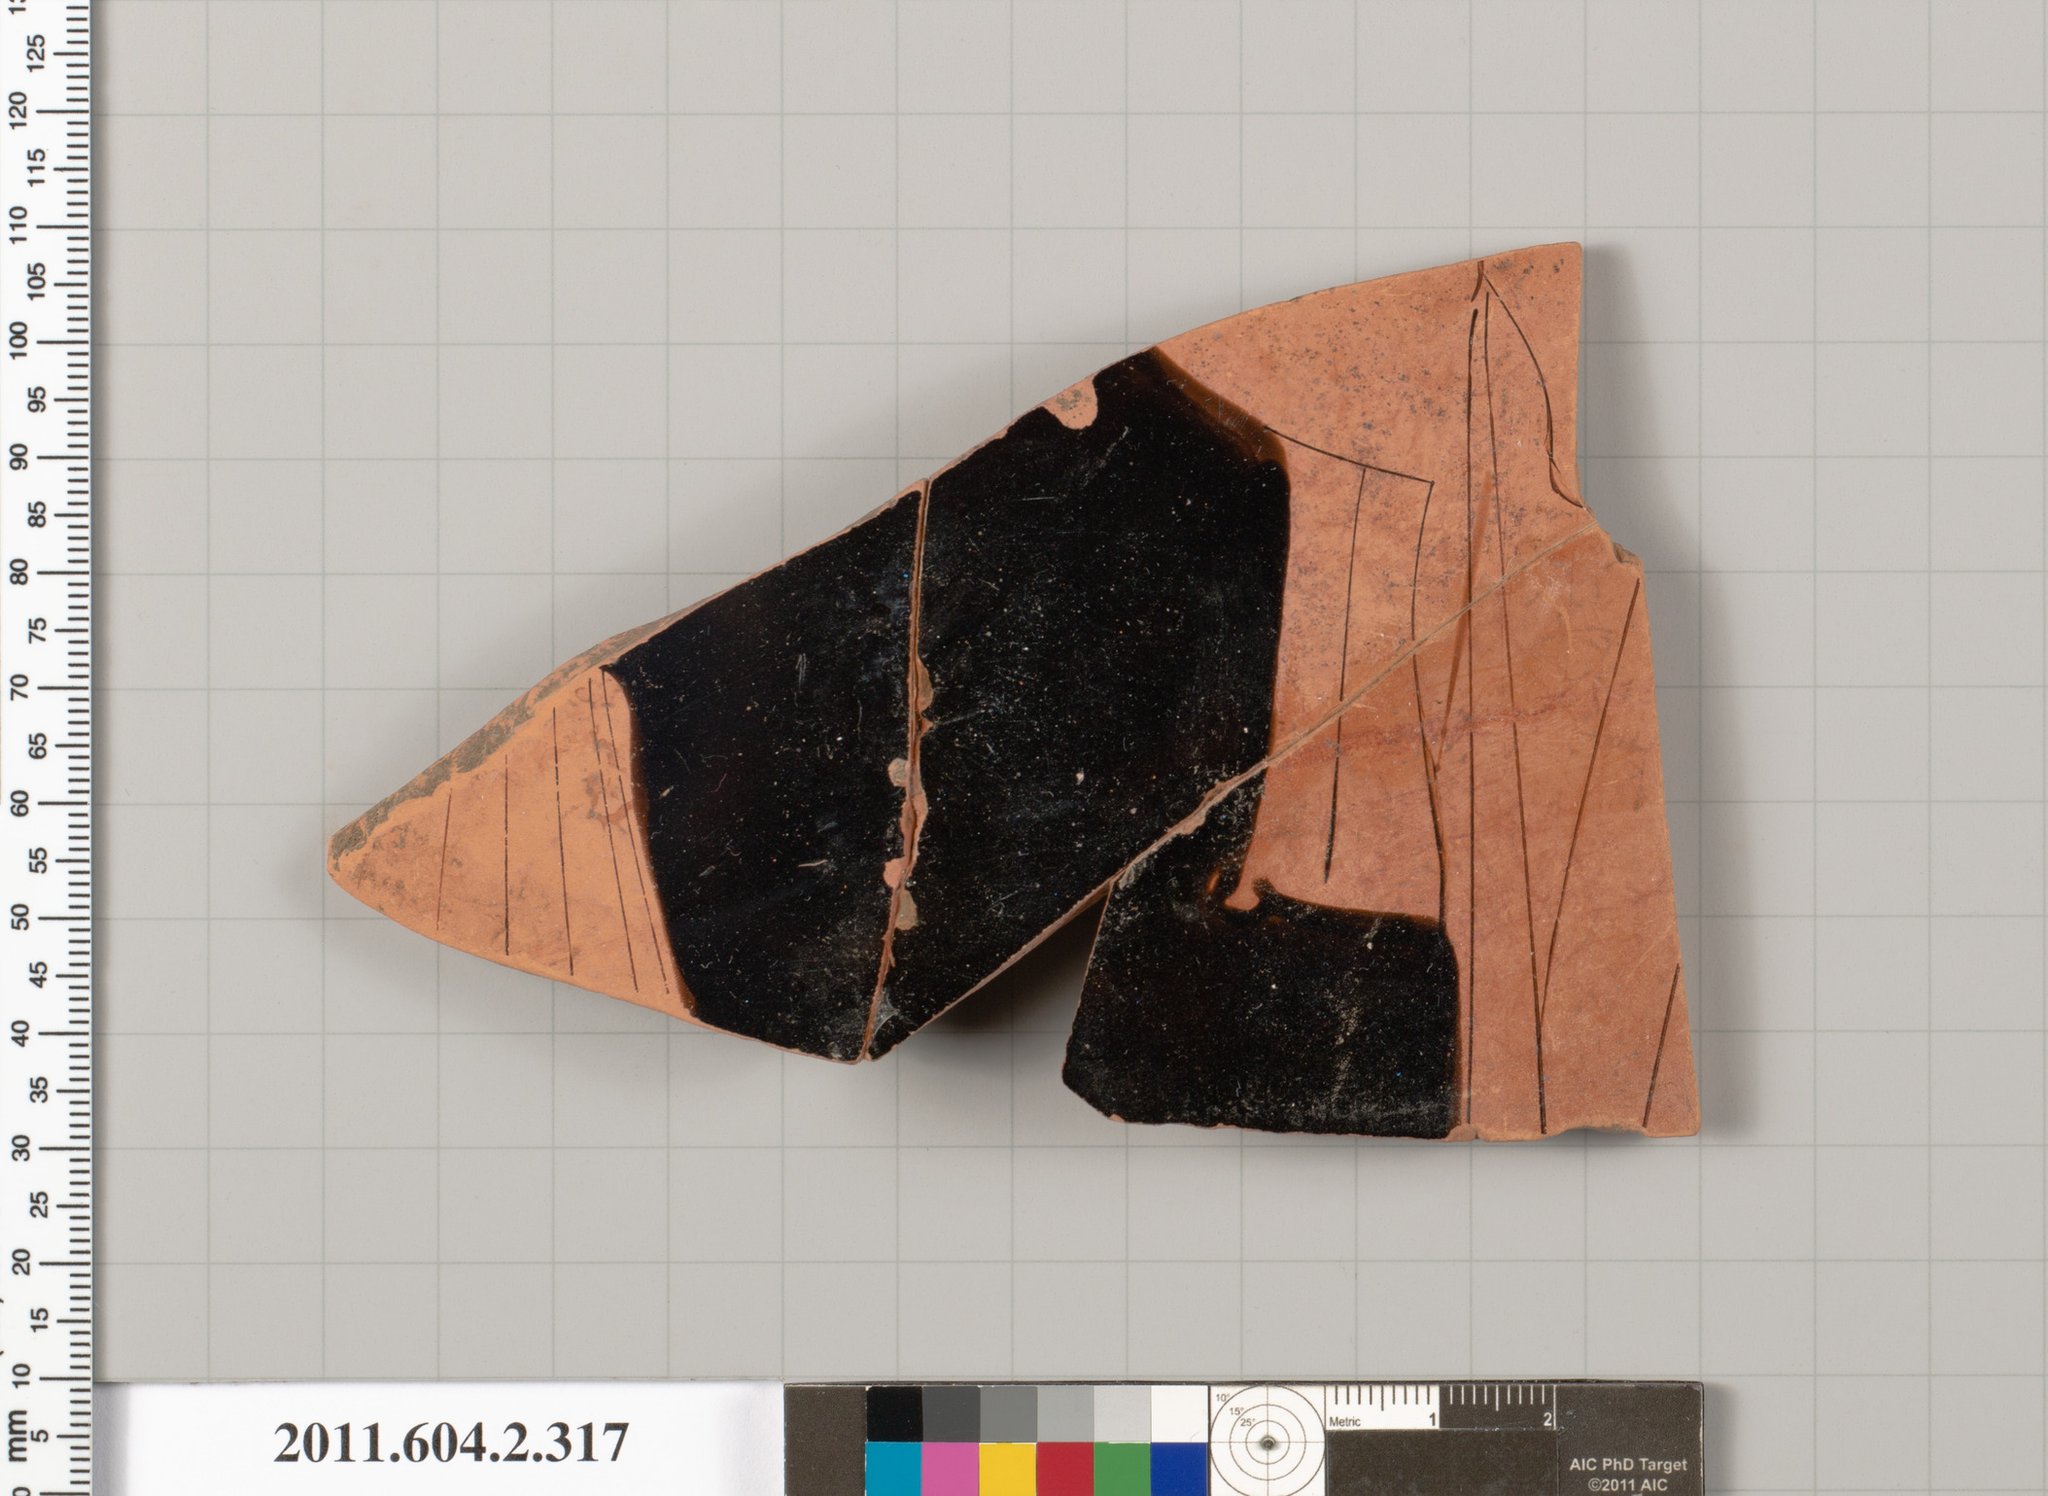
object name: column krater fragment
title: Terracotta fragment of a column-krater (bowl for mixing wine and water)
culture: greek, attic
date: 450-440 BCE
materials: terracotta